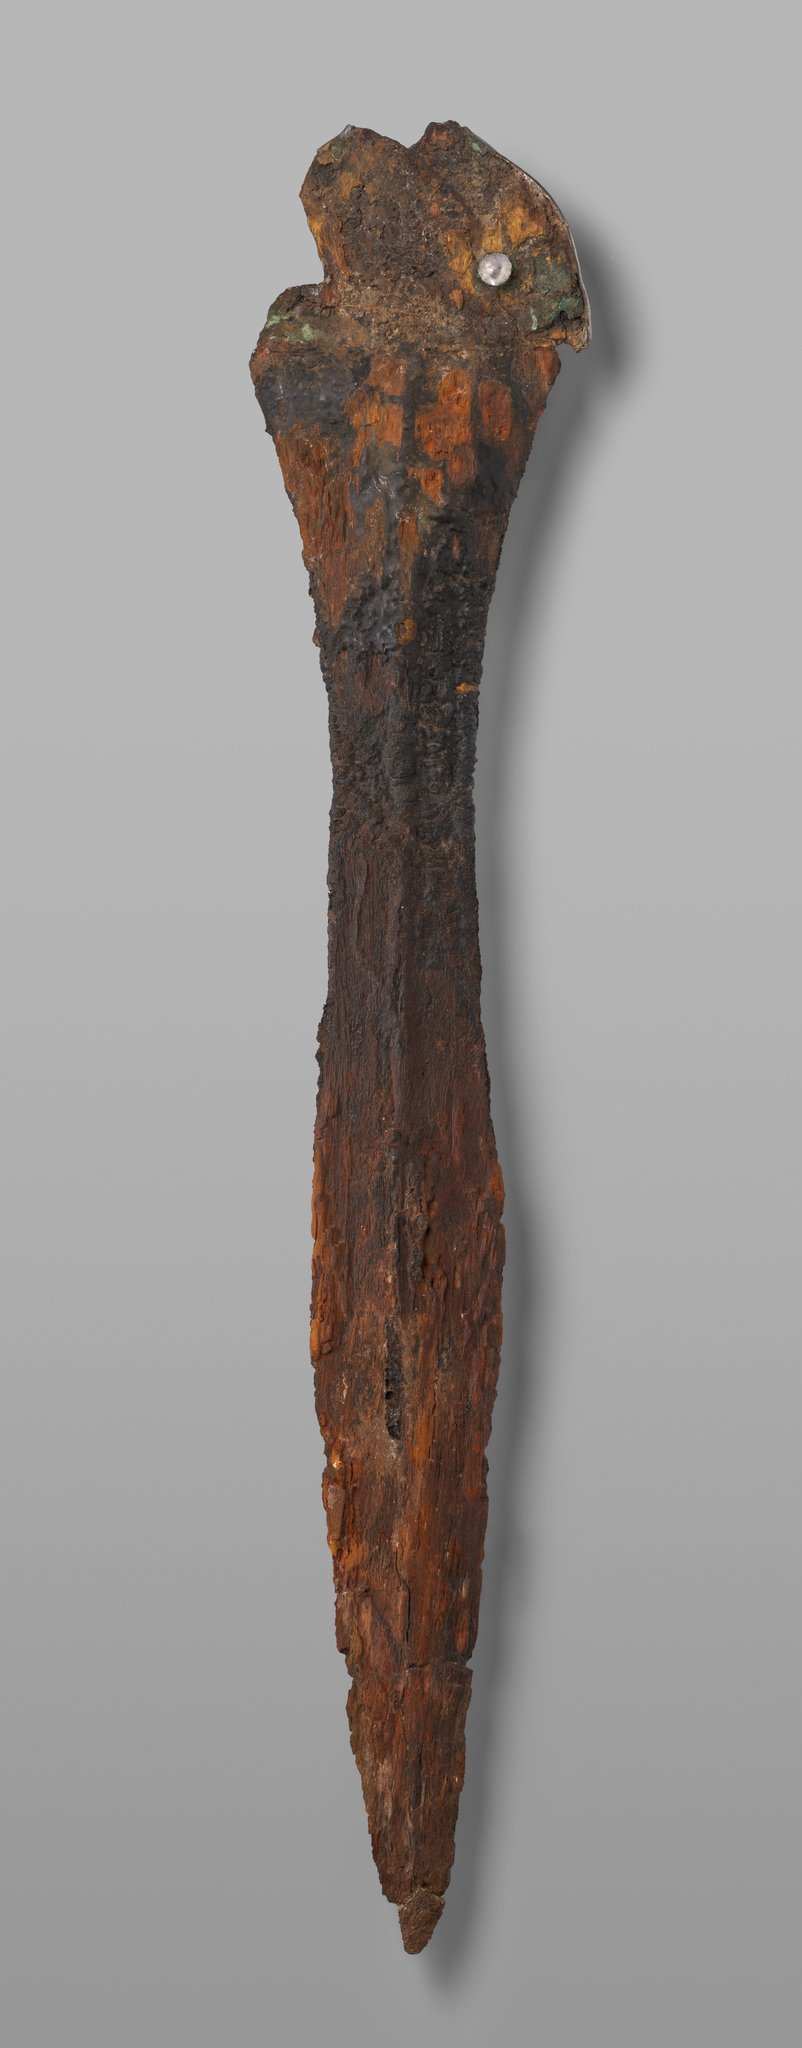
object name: sword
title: Iron, silver, and bronze sword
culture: cypriot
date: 600-501 BCE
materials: bronze, iron, silver